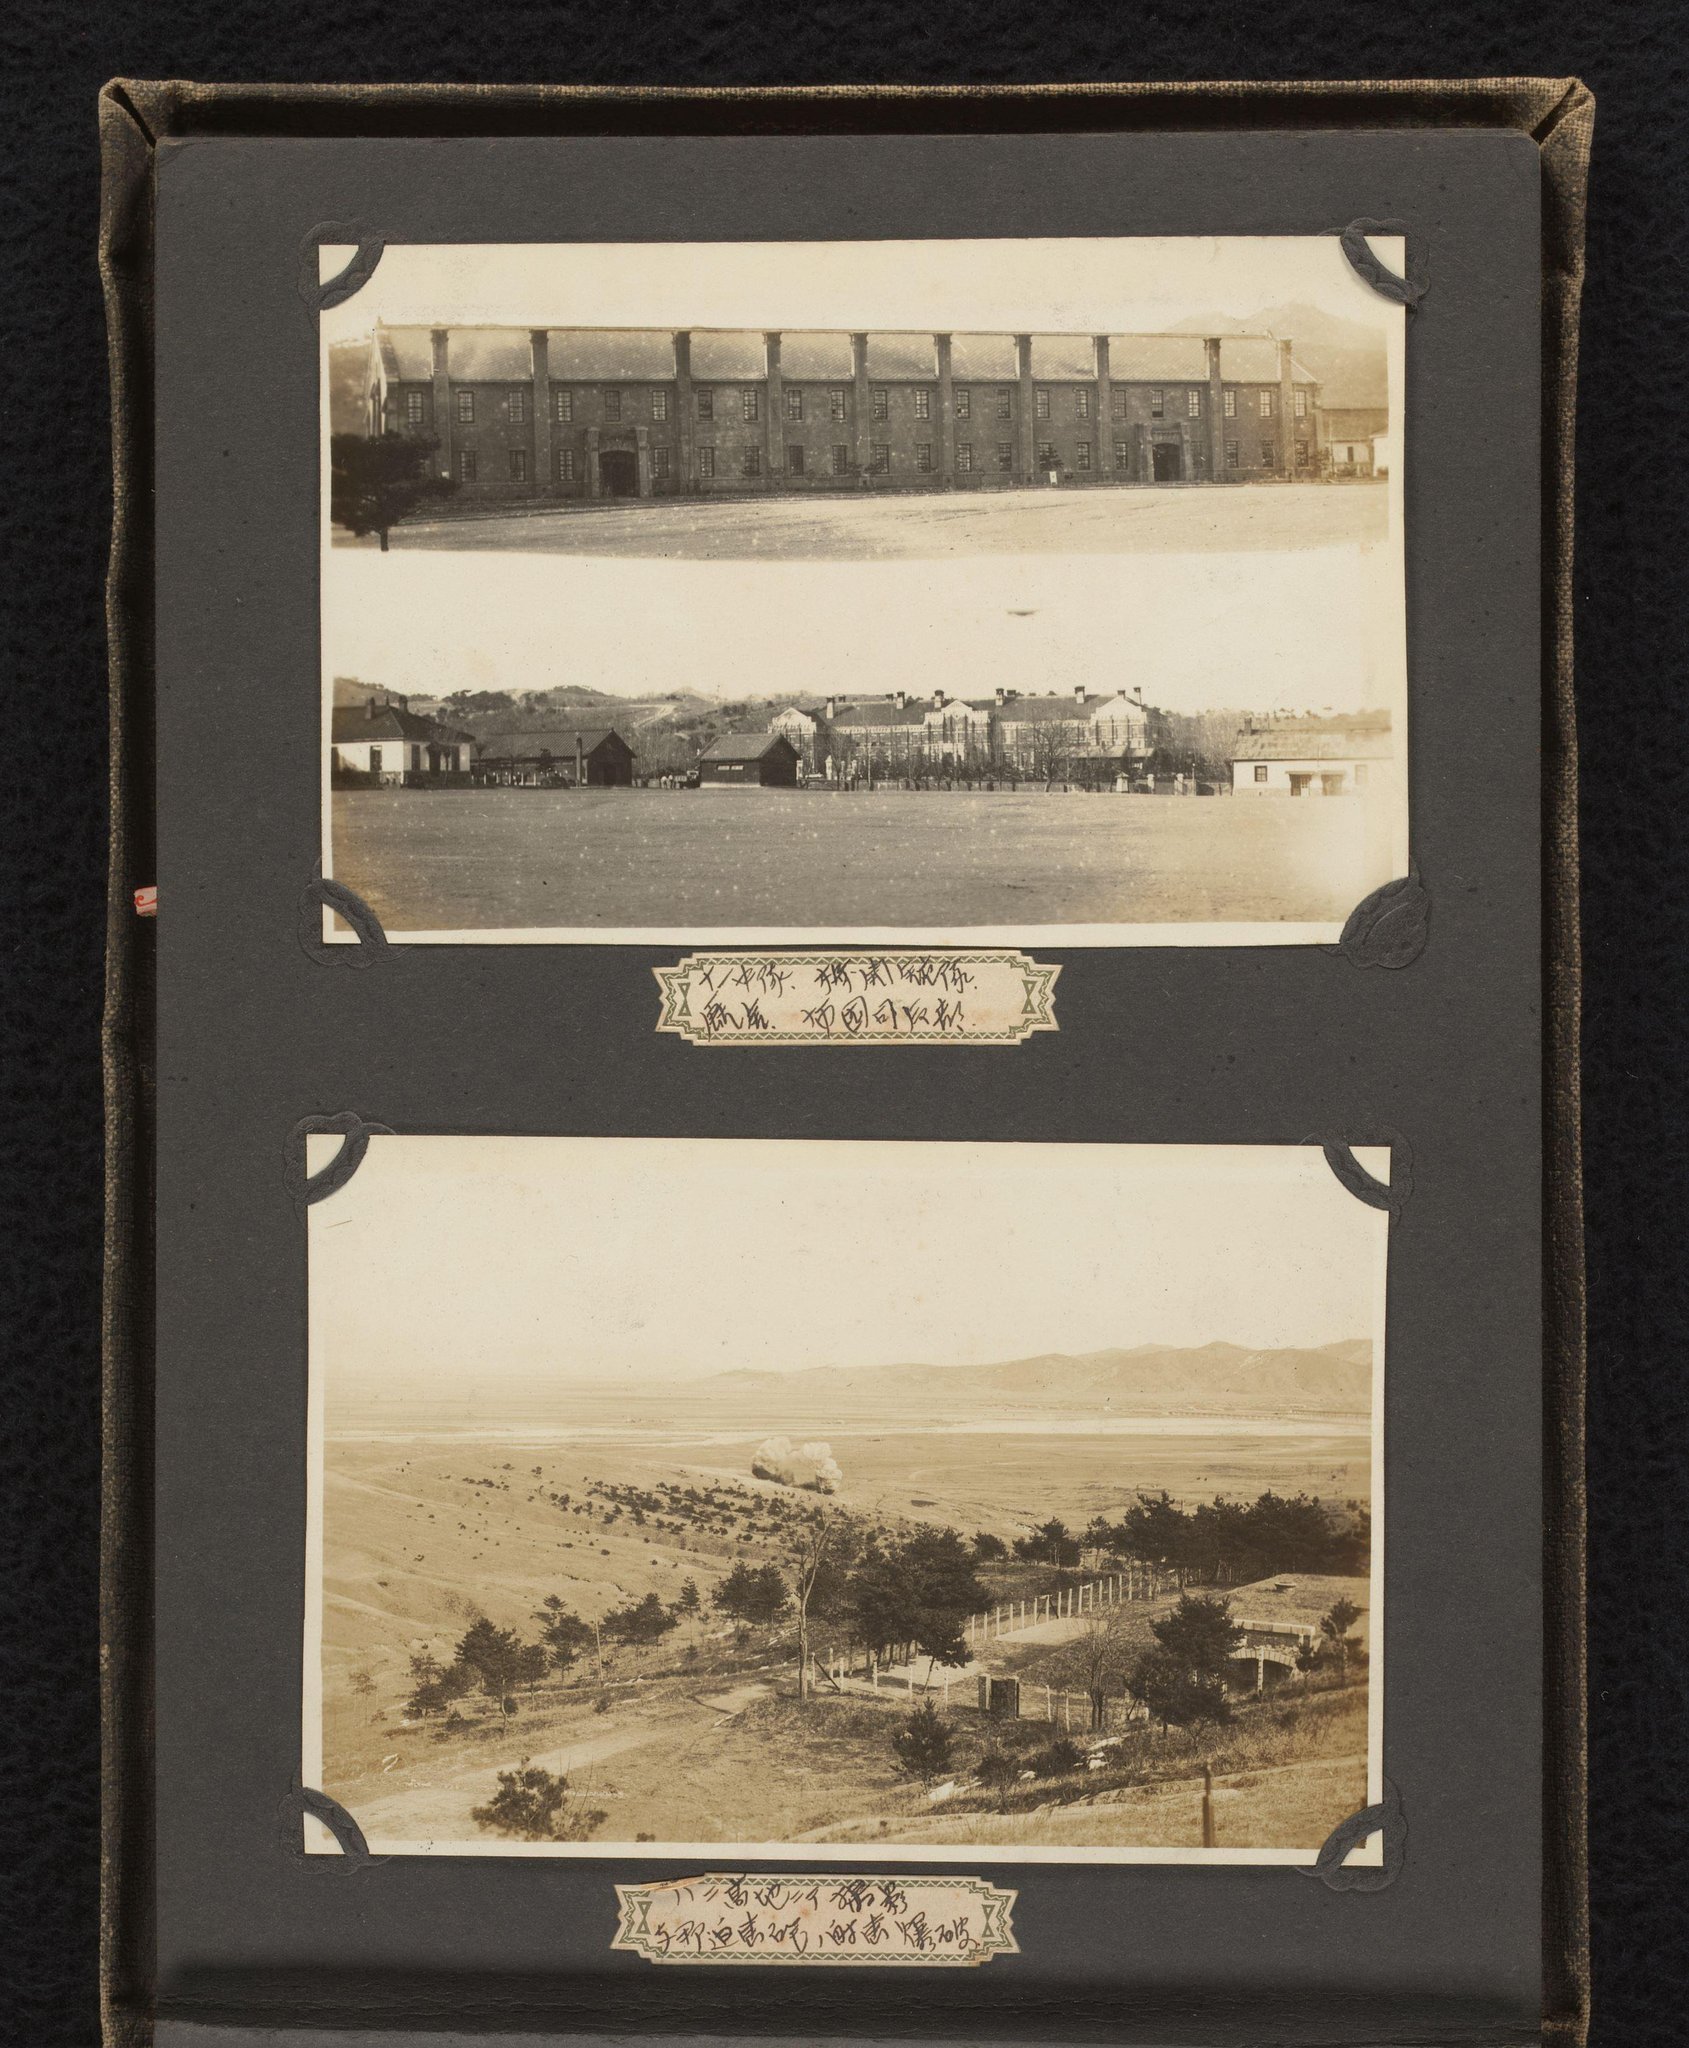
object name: album leaf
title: Gezicht op een landschap met legerbasis, vermoedelijk in Korea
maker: Anonymous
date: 1930-1940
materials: paper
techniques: gelatin silver print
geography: korea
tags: shelter ~ military service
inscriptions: inscription: ‘[...]’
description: Deze foto's zijn onderdeel van een album.